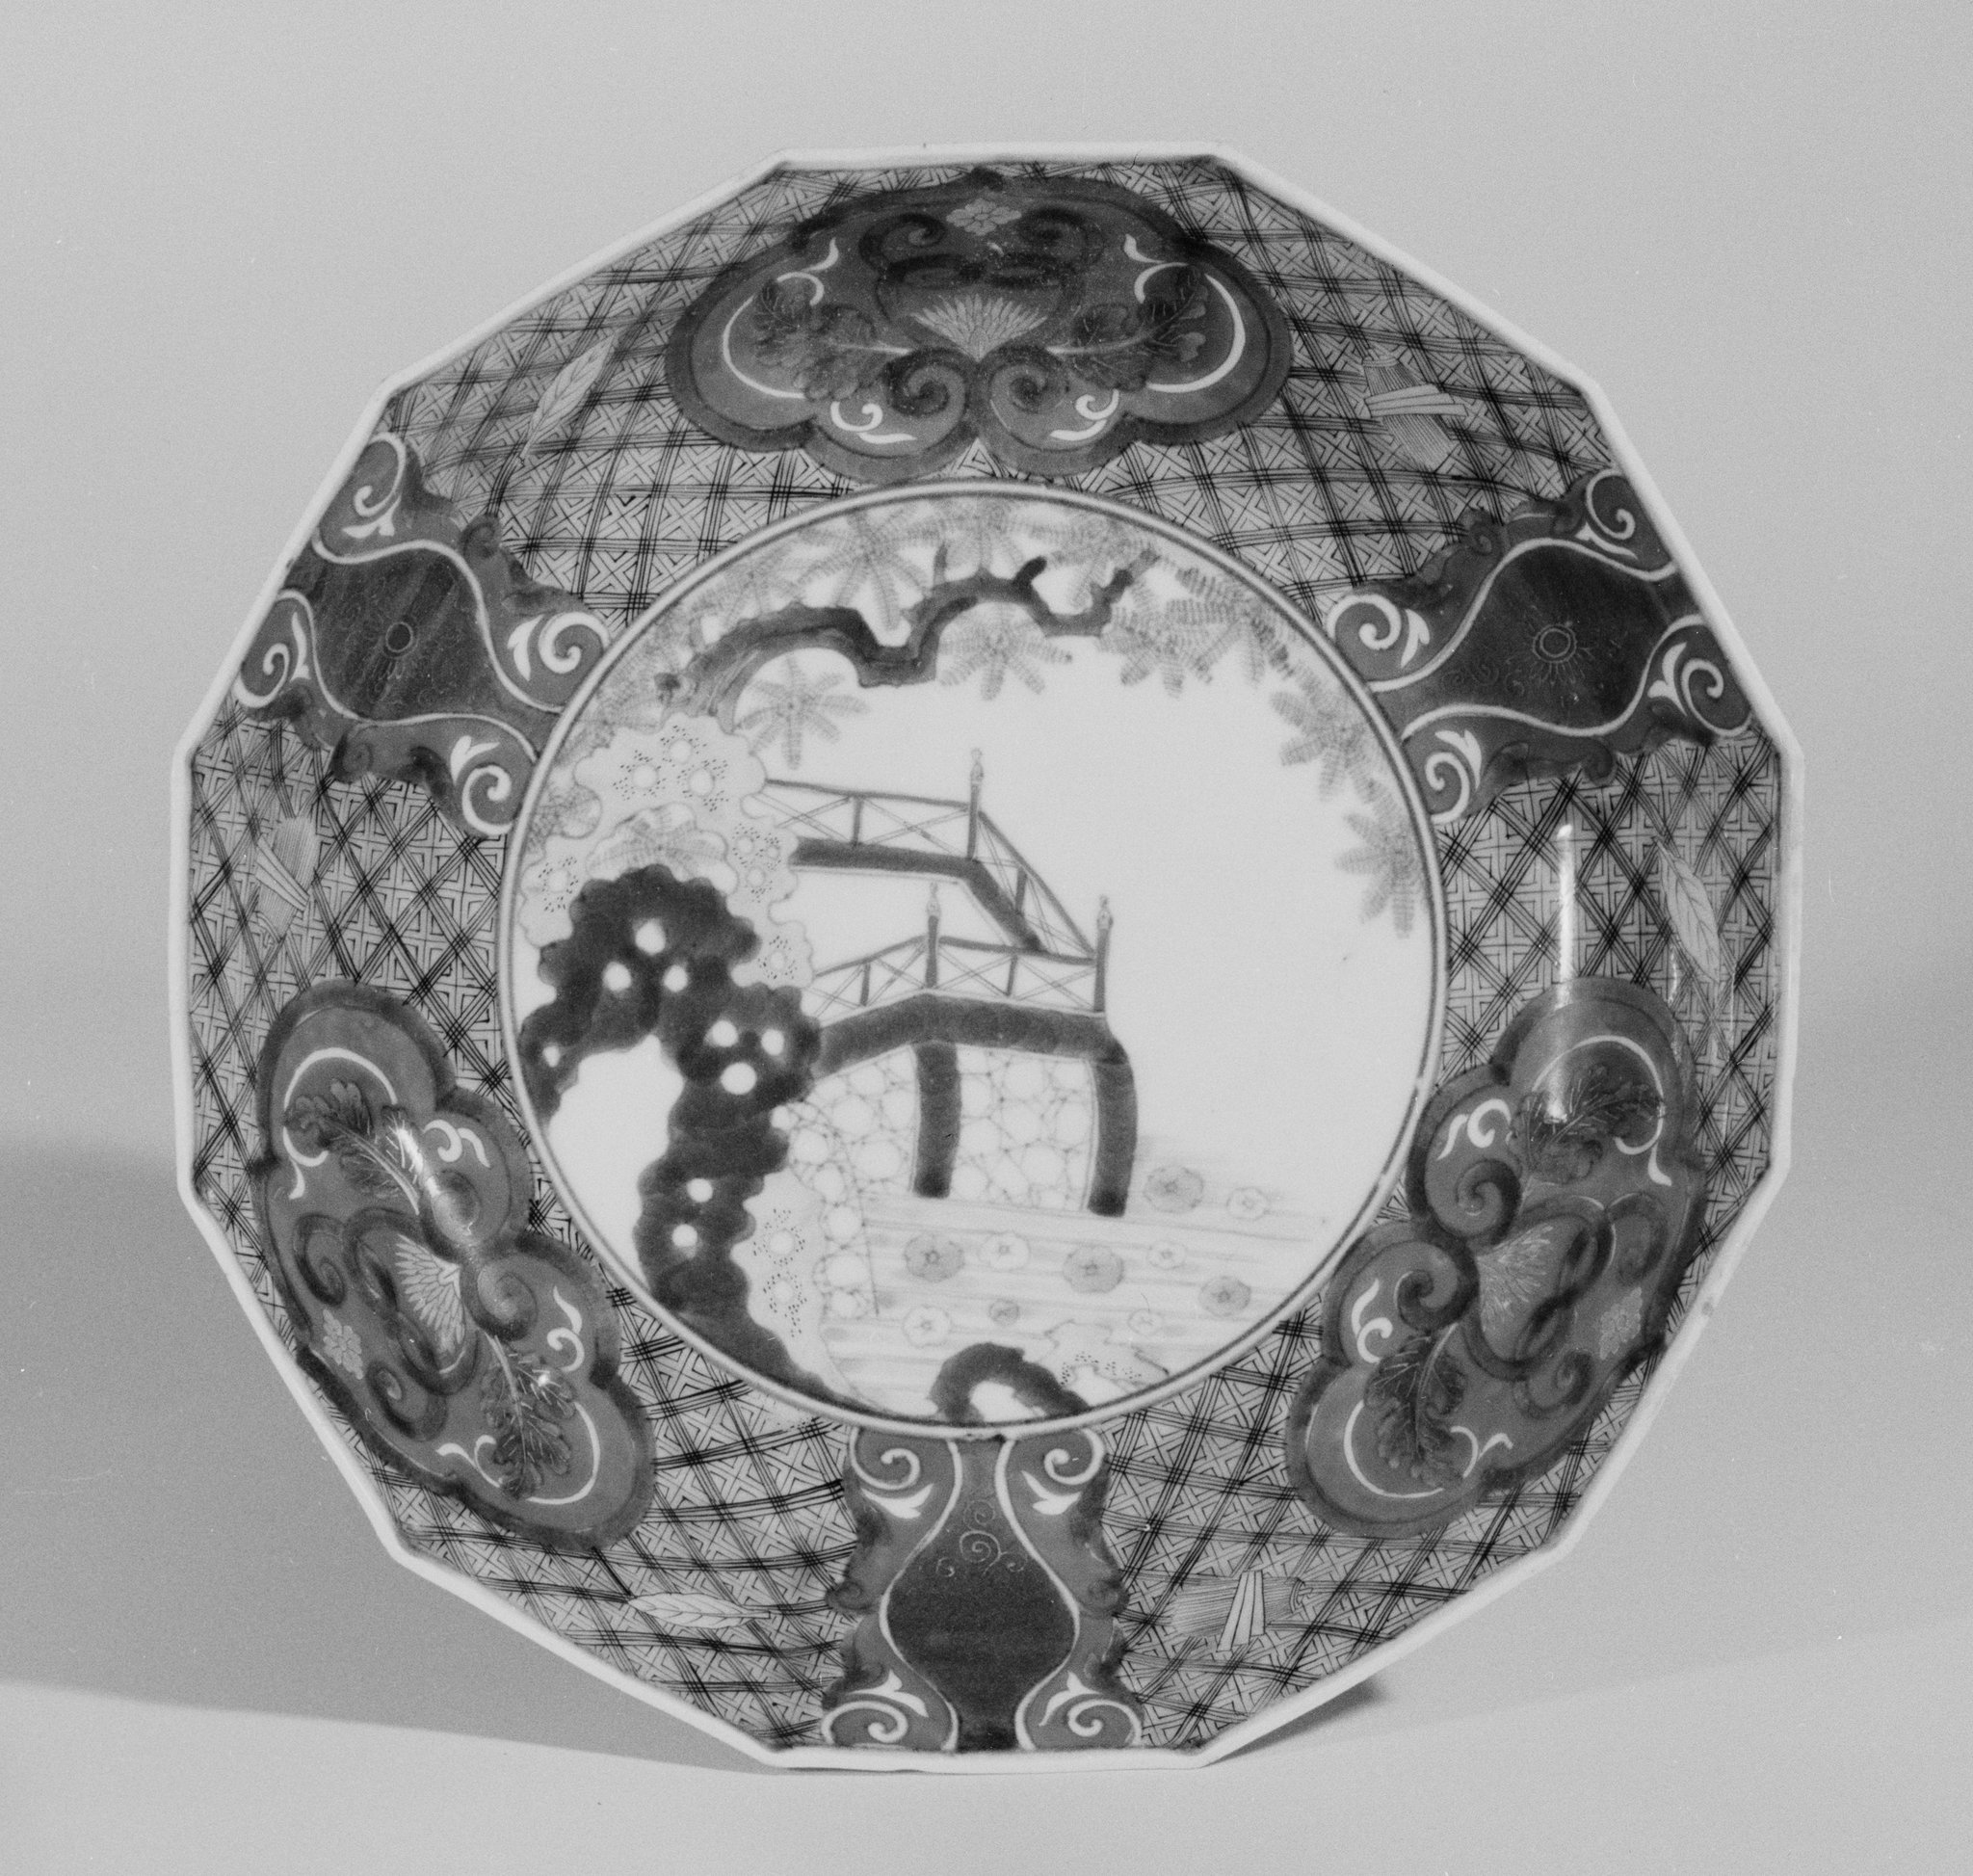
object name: plate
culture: japanese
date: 1701-1733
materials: enamel, gold, porcelain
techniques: polychrome